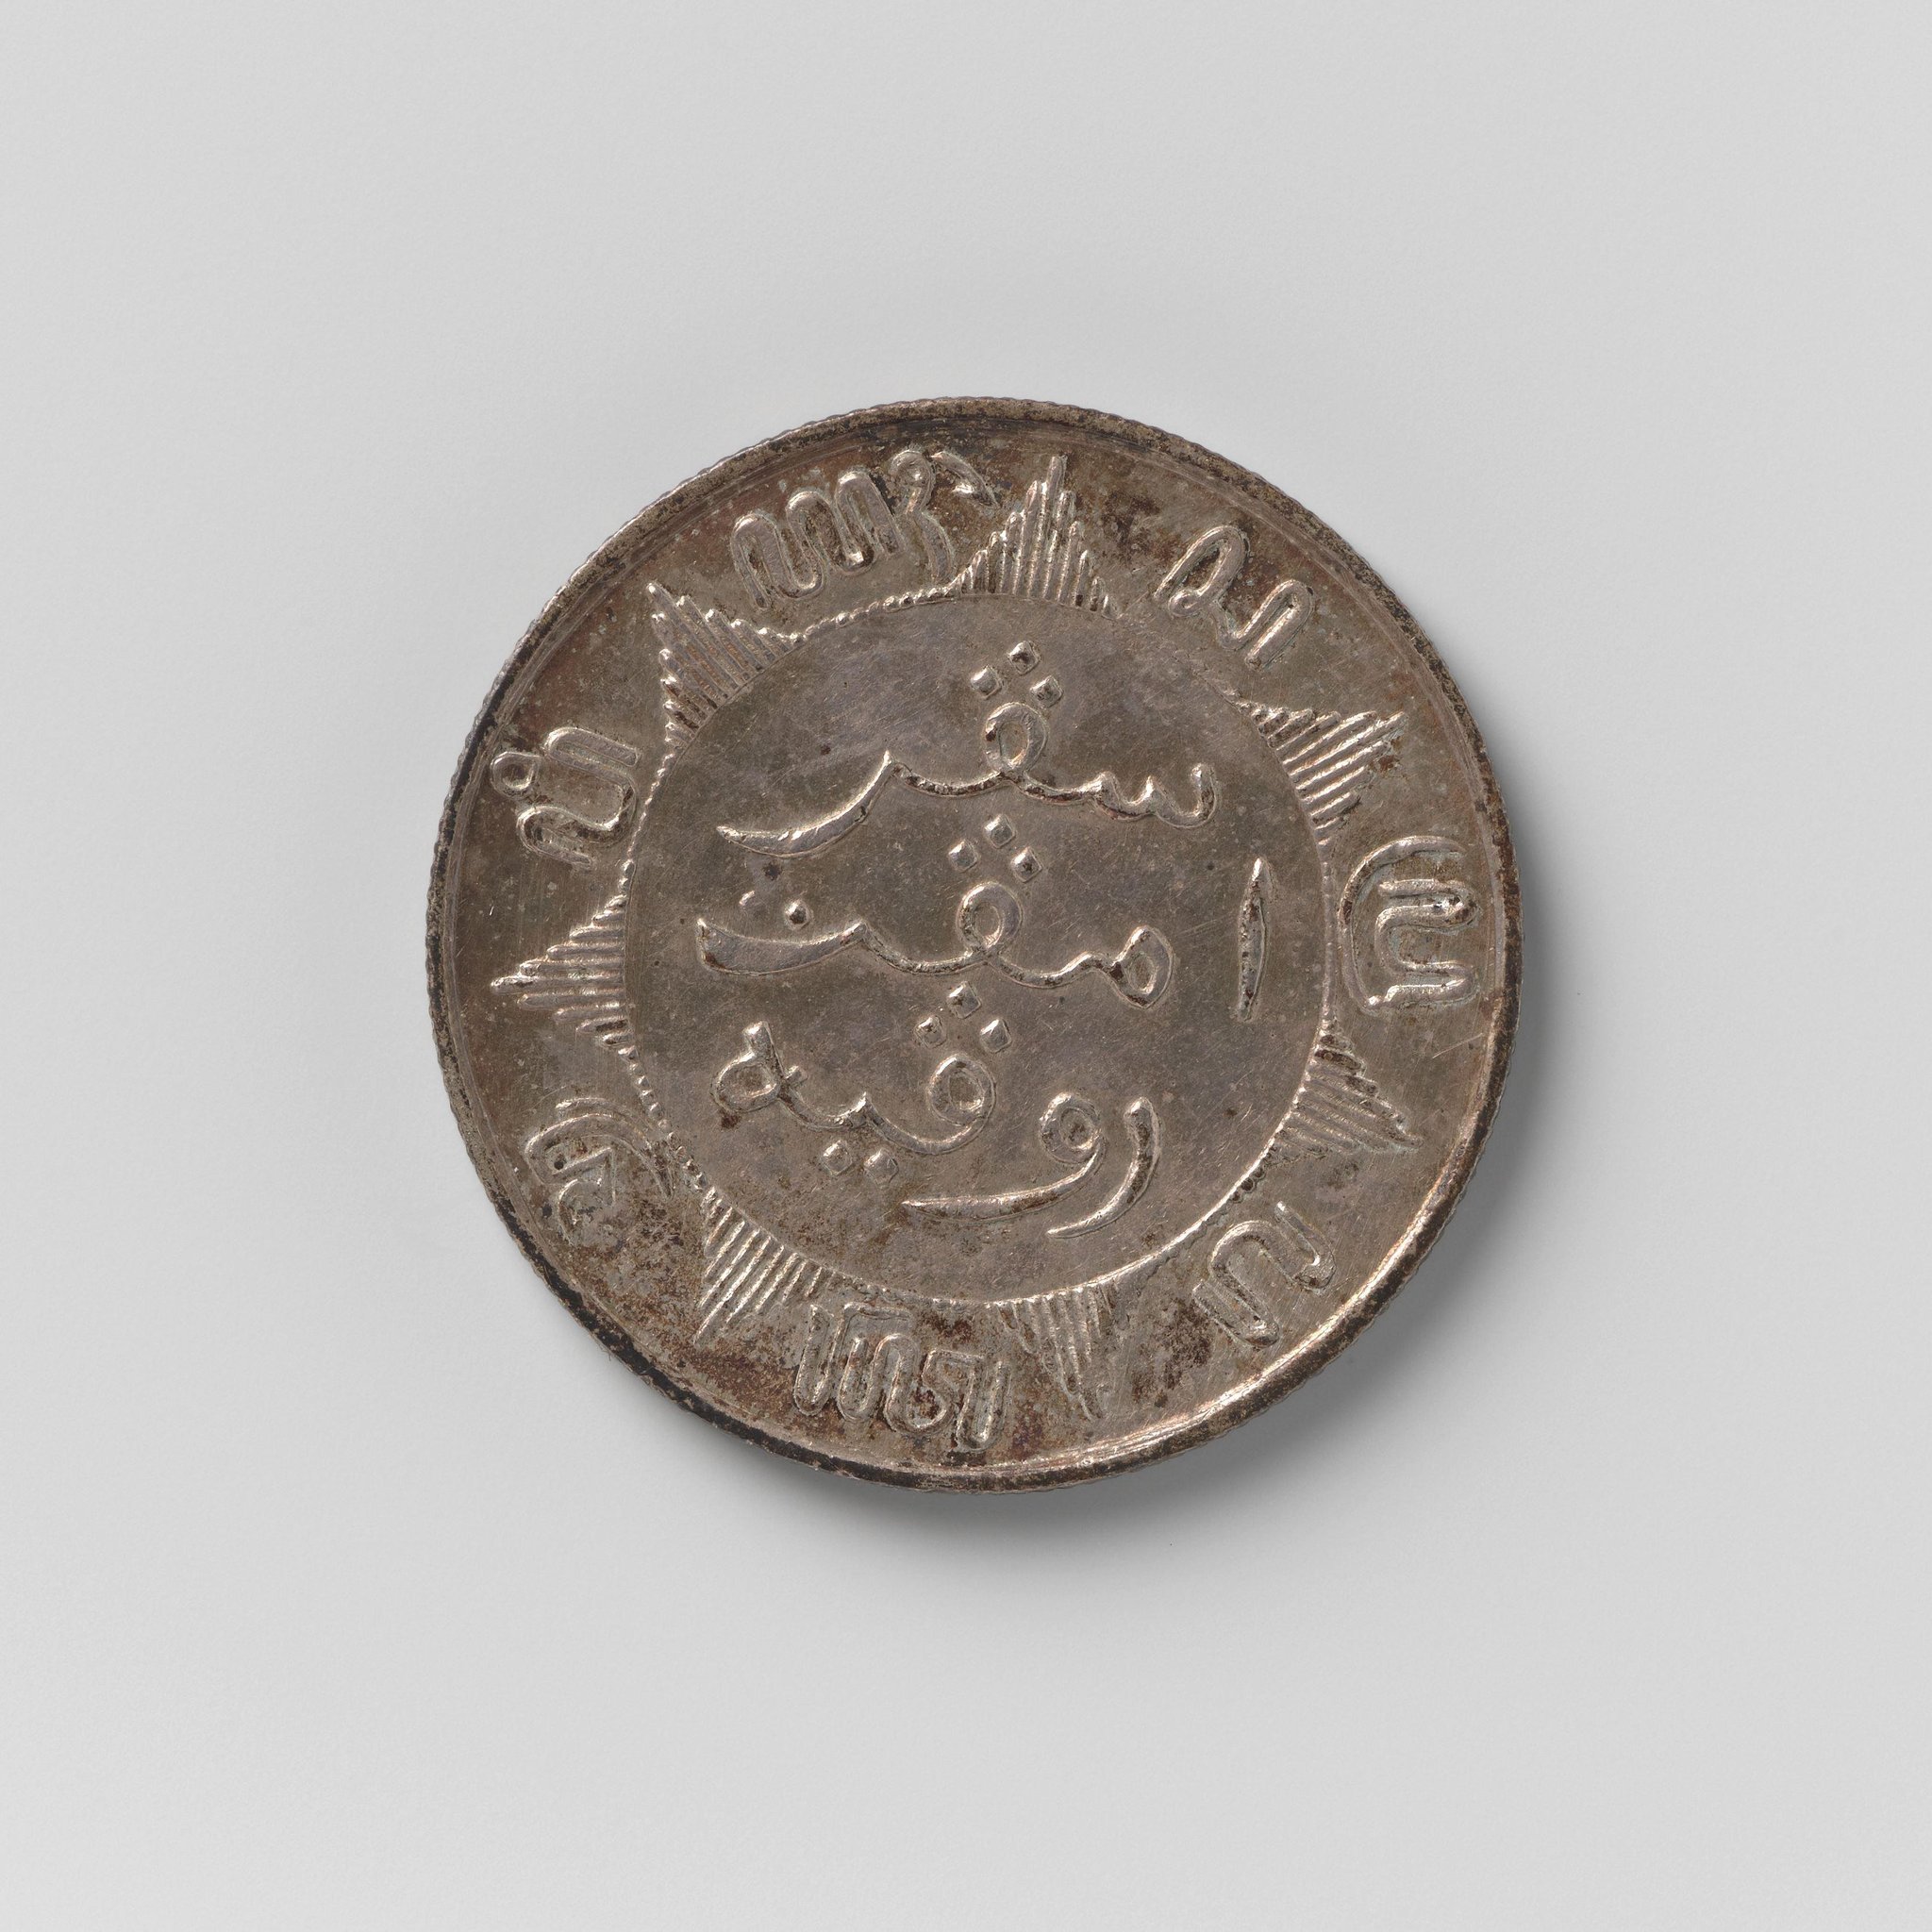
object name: coin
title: Nederlands Indië, 1/4 gulden, 1857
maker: willem iii (koning der nederlanden)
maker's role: koning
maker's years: 1817-1890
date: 1857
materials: silver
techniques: striking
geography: utrecht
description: Zilveren munt. Voorzijde: tussen waarde-aanduiding 1/4 G gekroond rijkswapenschild. Boven kroon landsaanduiding en onder wapenschild jaartal. Keerzijde: drieregelig Maleis opschrift in Arabische tekens, waaromheen tussen zeven uitschietende stralen omschrift in het Javaans. Kartelrand.